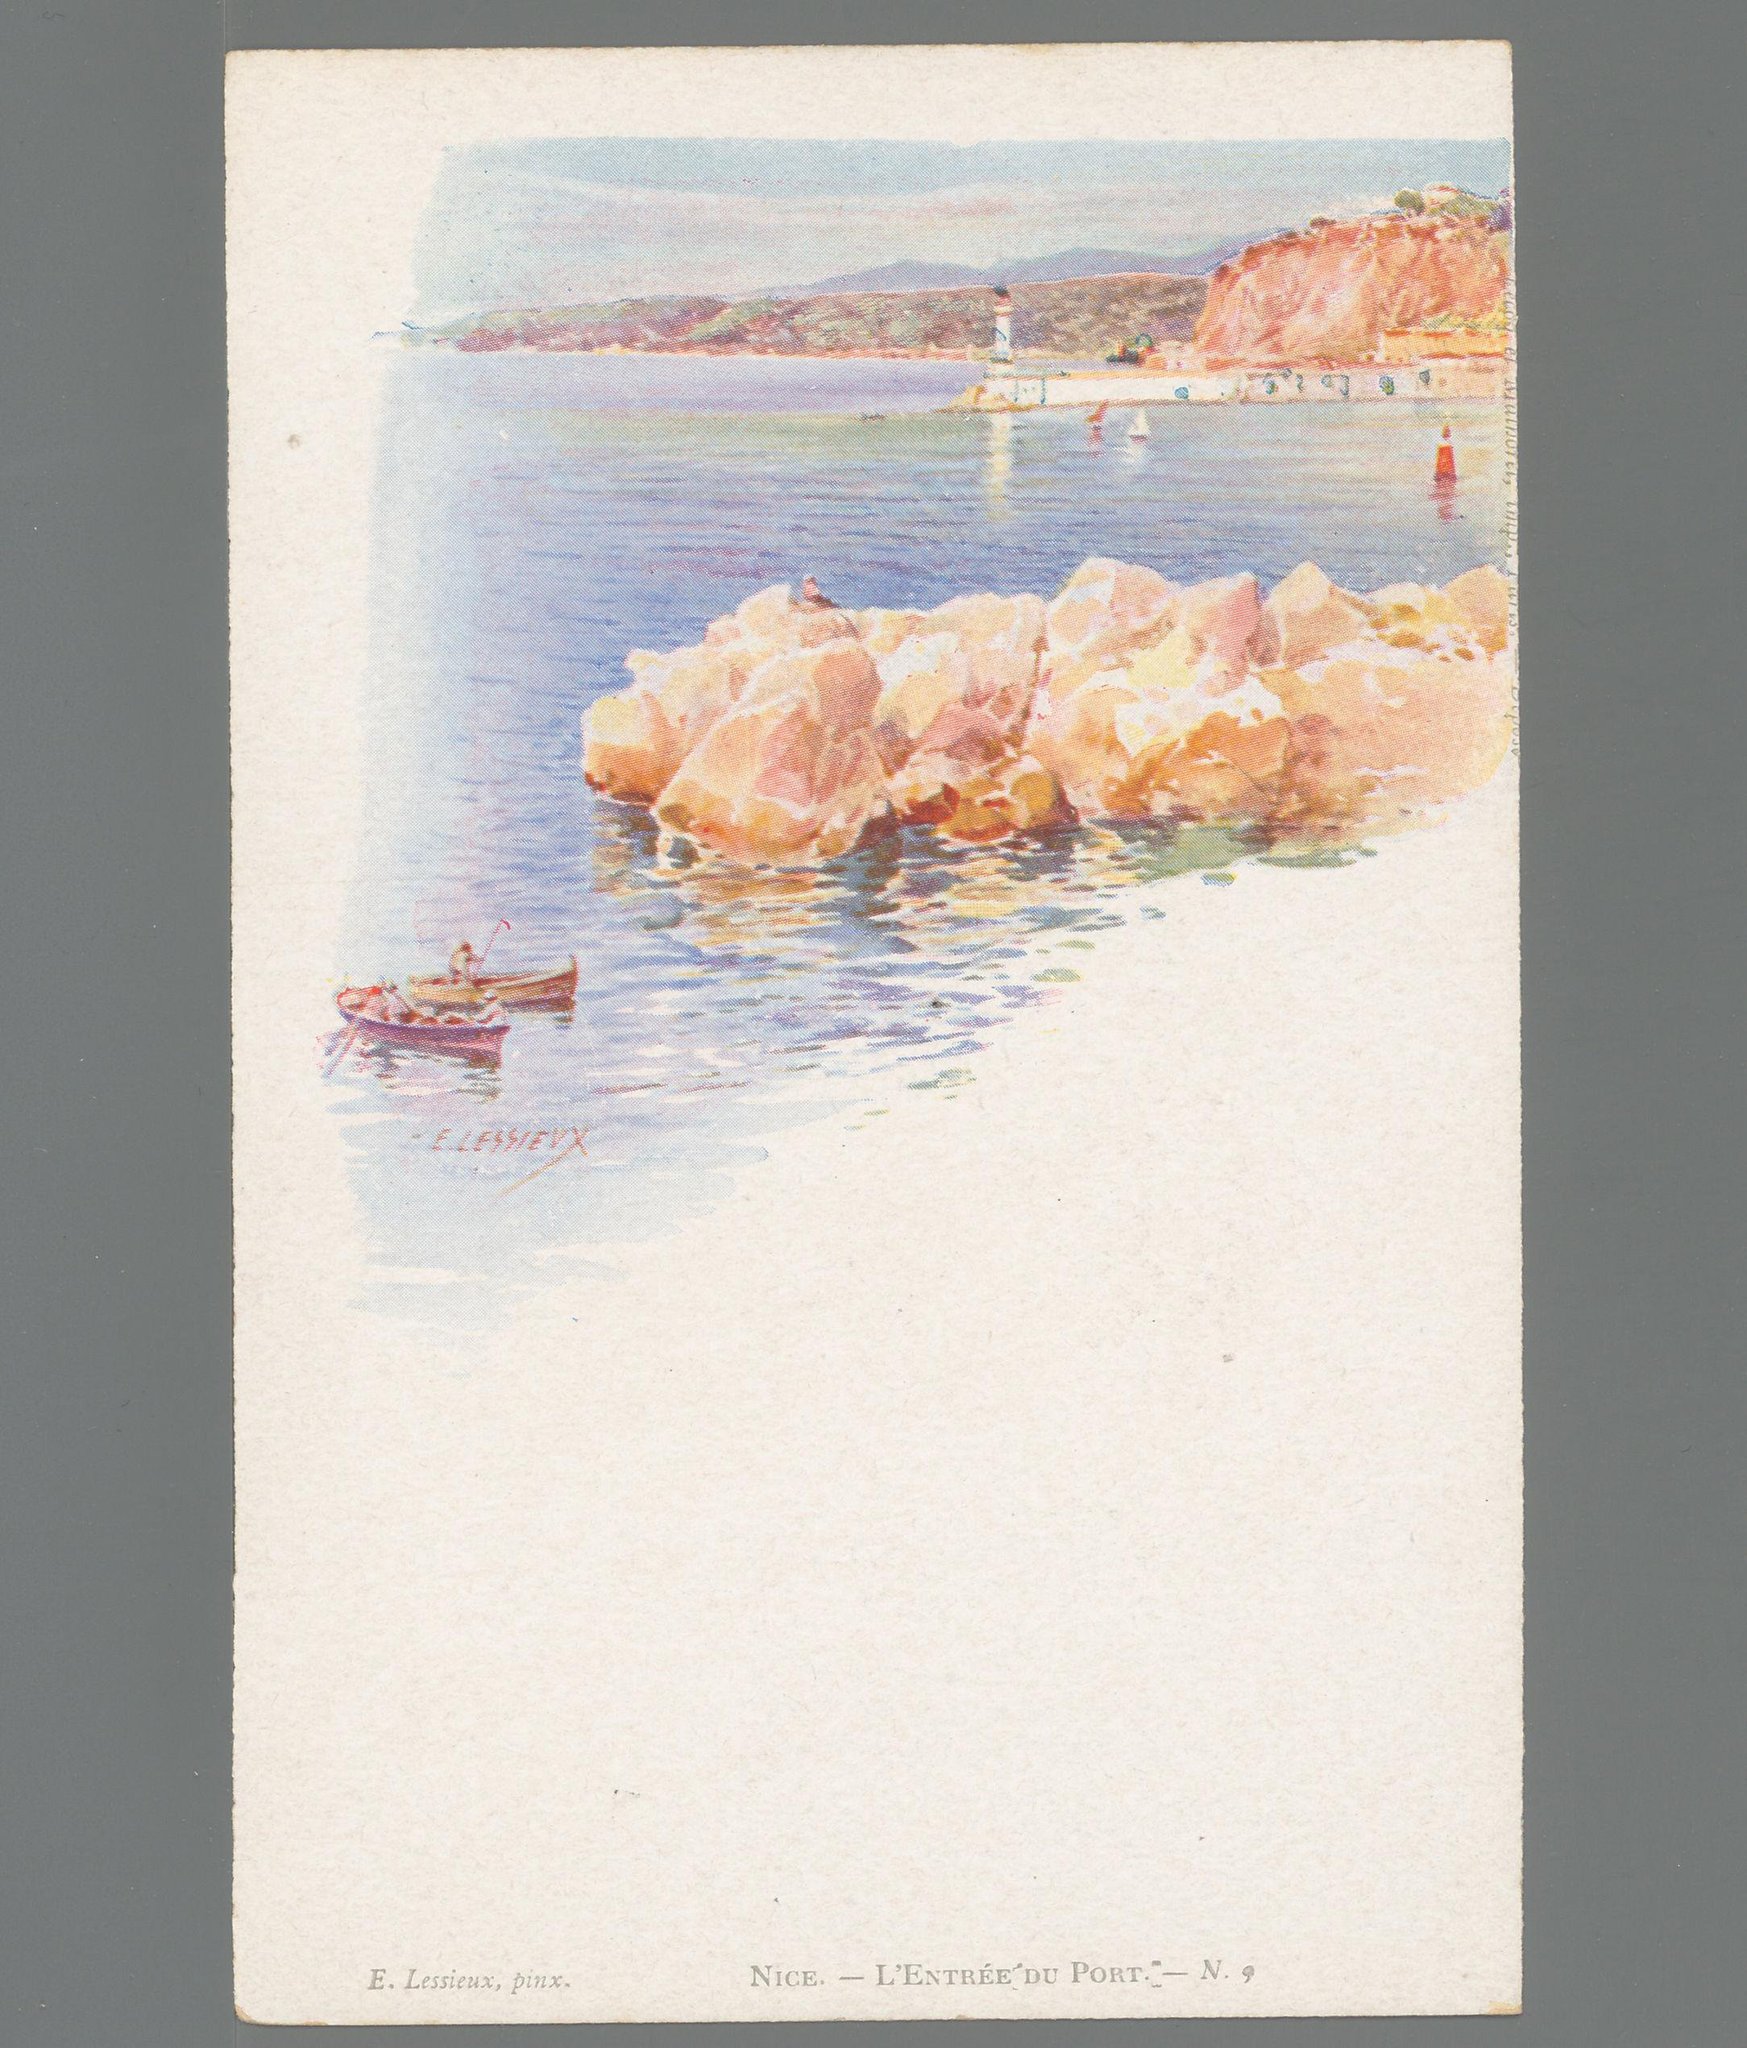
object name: photomechanical print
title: Nice. L'Entrée du Port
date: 1892-1904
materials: cardboard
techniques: writing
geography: paris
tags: harbour, landscapes with waters, waterscapes, seascapes (in the temperate zone)